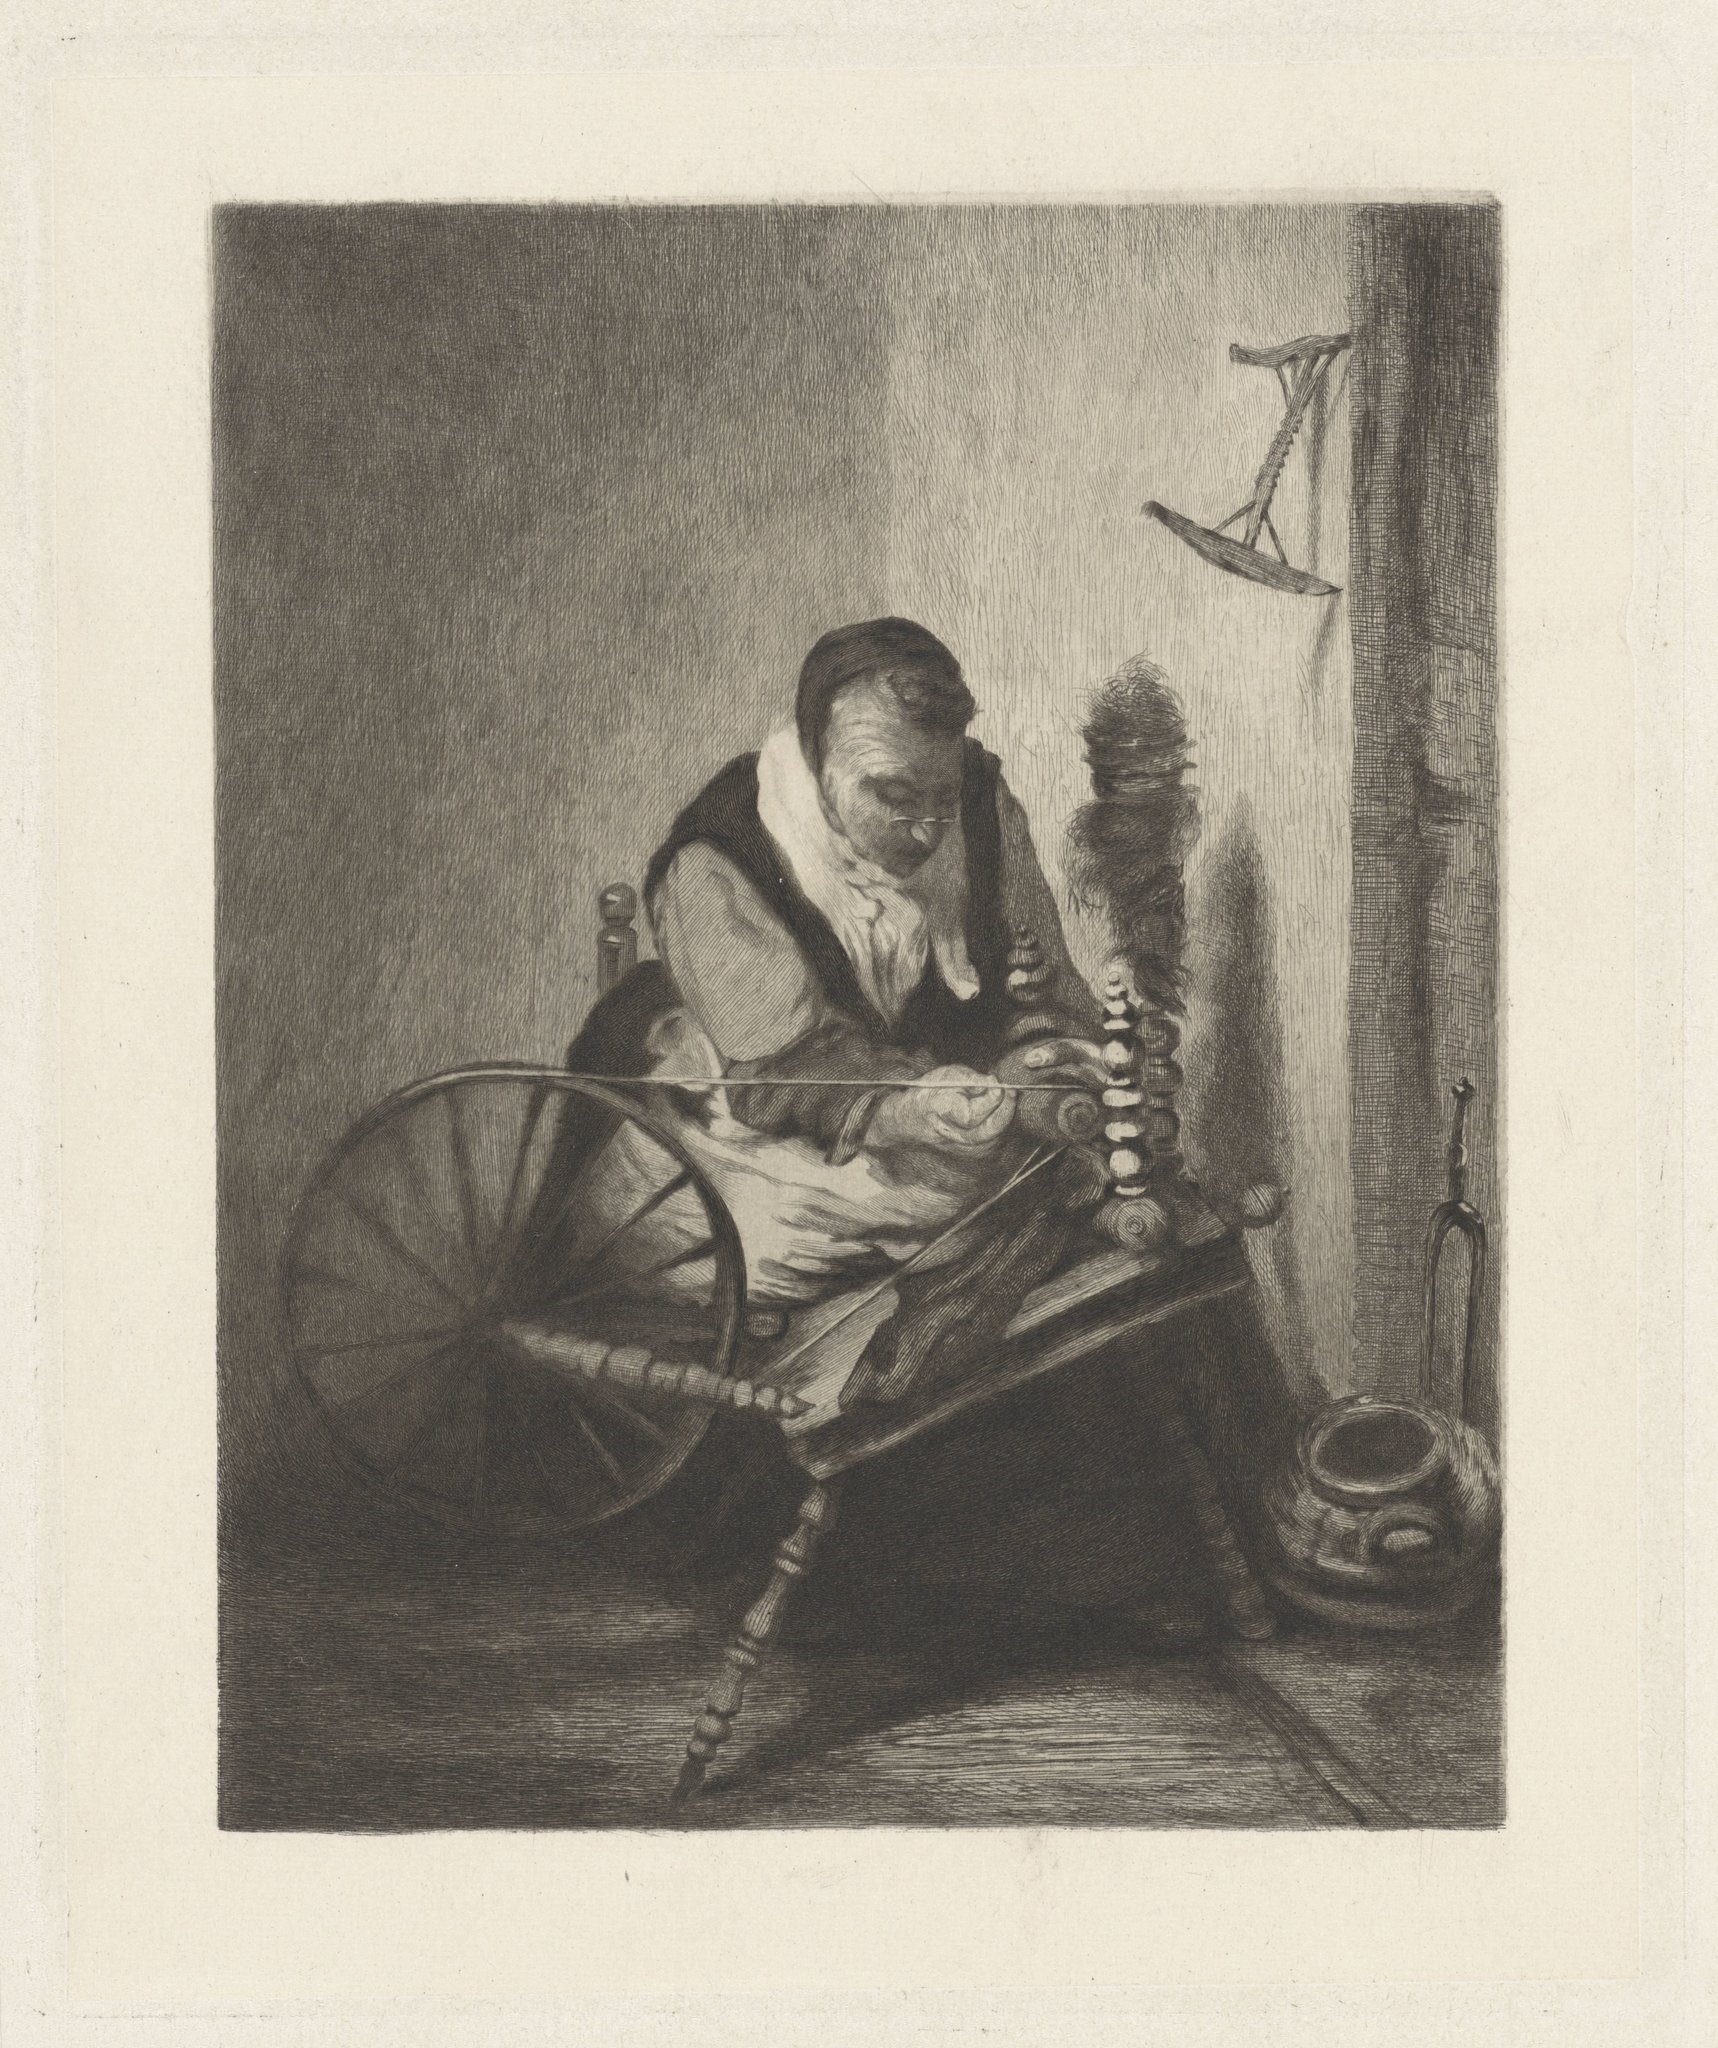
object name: print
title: De spinster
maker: willem steelink (ii)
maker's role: draughtsman, print maker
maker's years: 1856-1928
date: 1866-1890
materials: paper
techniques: engraving, etching, intaglio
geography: netherlands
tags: spinning-wheel, spinning (manufacture of yarn)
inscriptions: collector's mark: Lugt 2228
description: De spinster. Een oude vrouw, wol spinnend in de hoek van een kamer. Aan de muur hangt een haspel.